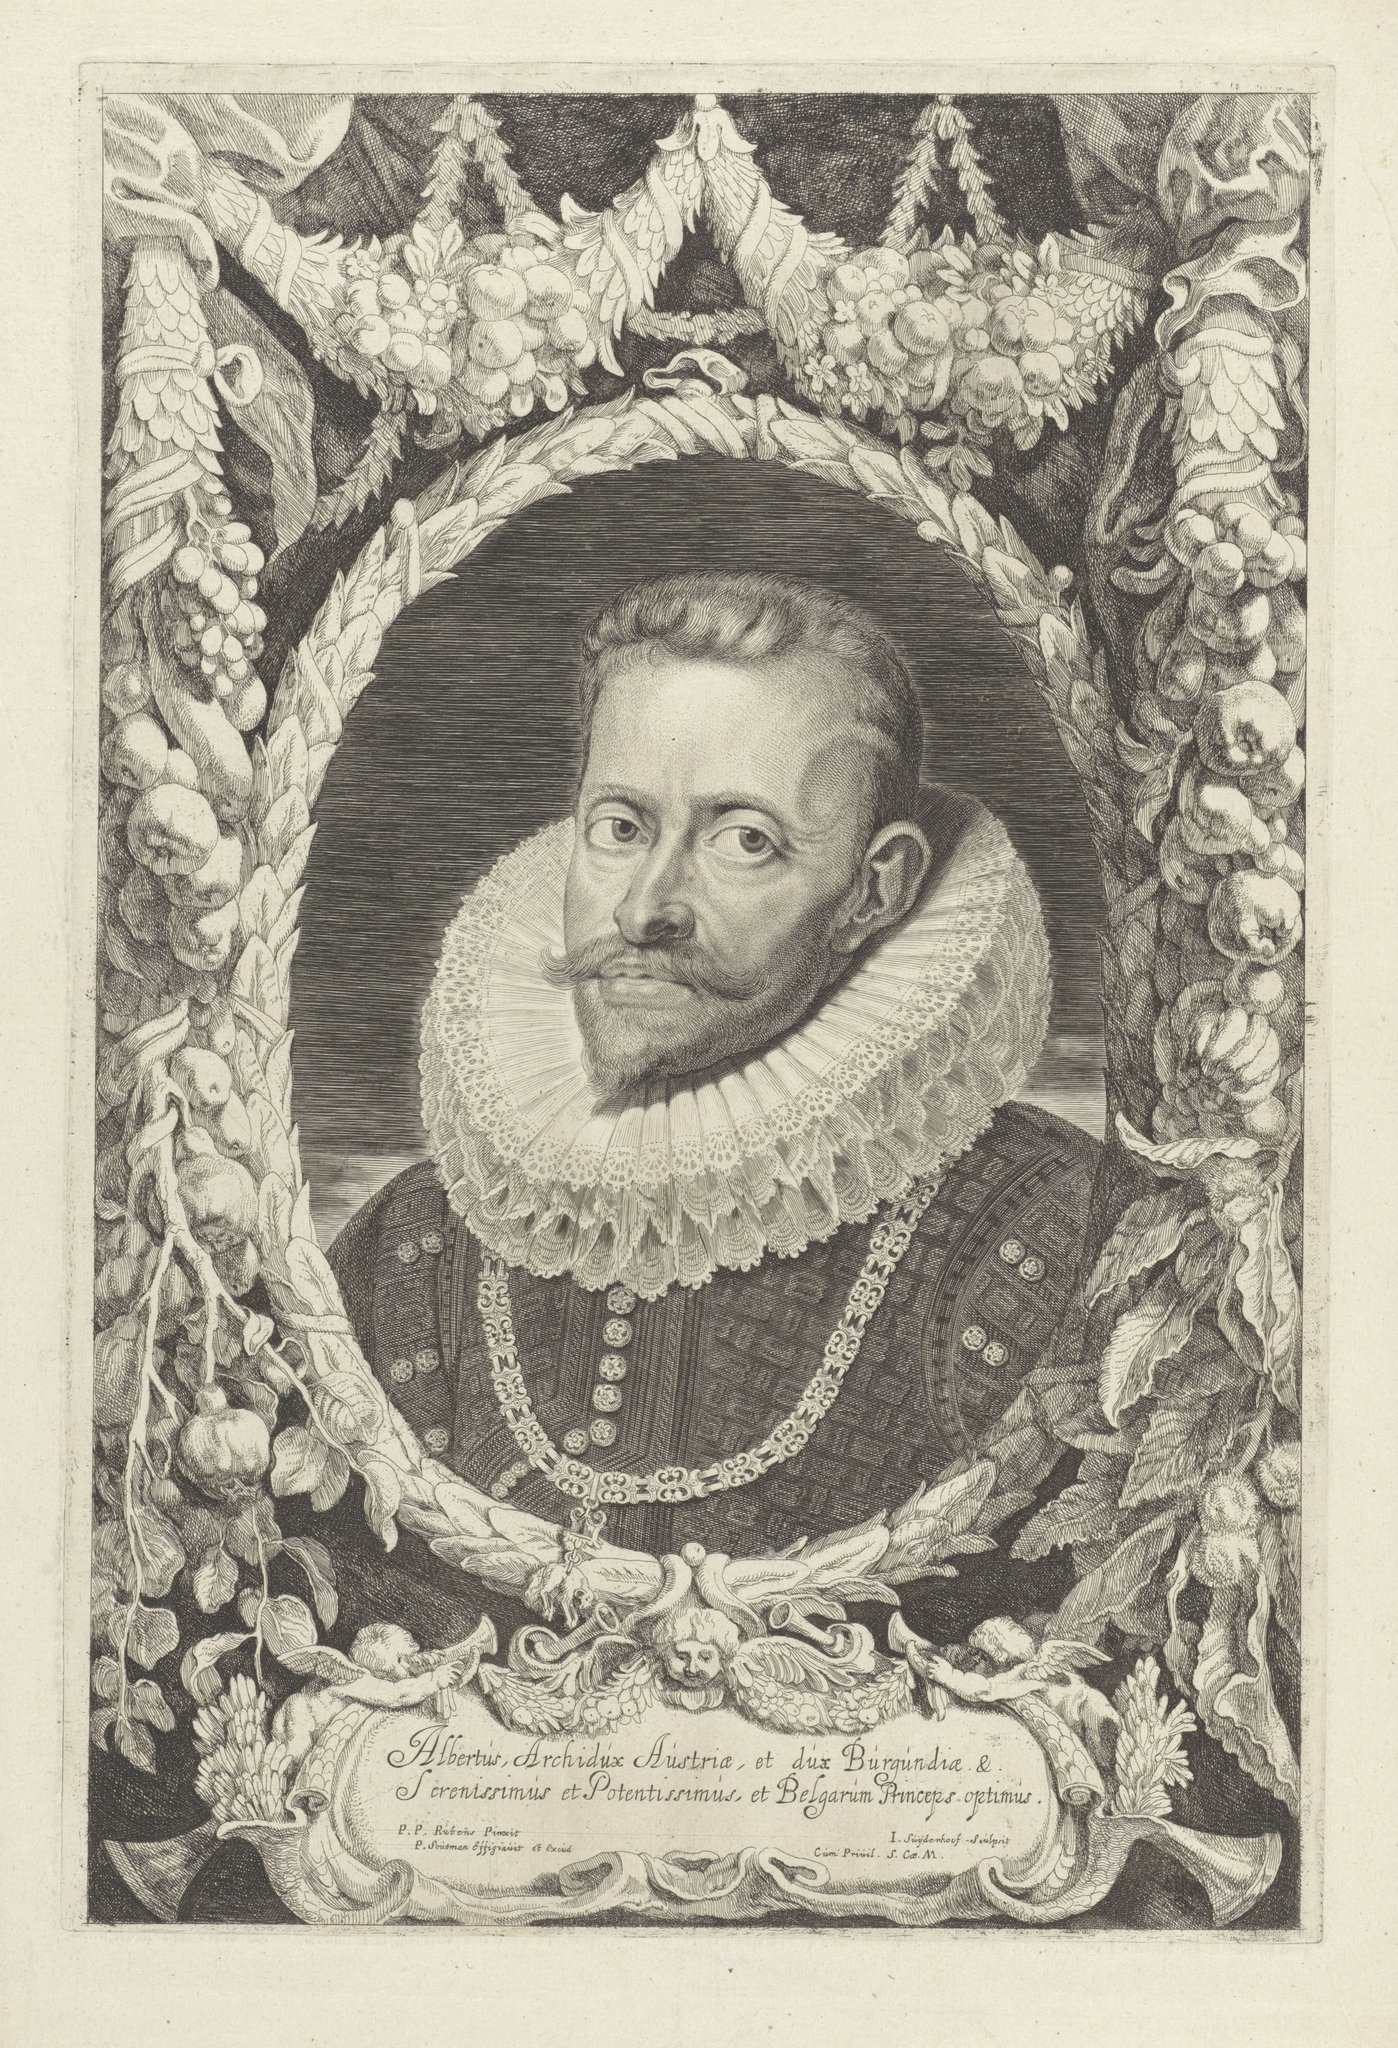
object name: print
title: Portret van aartshertog Albrecht van Oostenrijk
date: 1644-1650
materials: paper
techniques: engraving, etching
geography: haarlem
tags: brussels, albrecht aartshertog van oostenrijk, knighthood order of the golden fleece - insignia of a knighthood order, e.g.: badge, chain (with name of order), ornament ~ festoon, garland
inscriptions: collector's mark: Lugt 2233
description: Portret van Albrecht, aartshertog van Oostenrijk, met een keten met het ordeteken van de Orde van het Gulden Vlies om zijn hals. Het portret is gevat in een ornamentele omlijsting met guirlandes van vruchten. Midden onder een cartouche met zijn naam en titel in het Latijn.